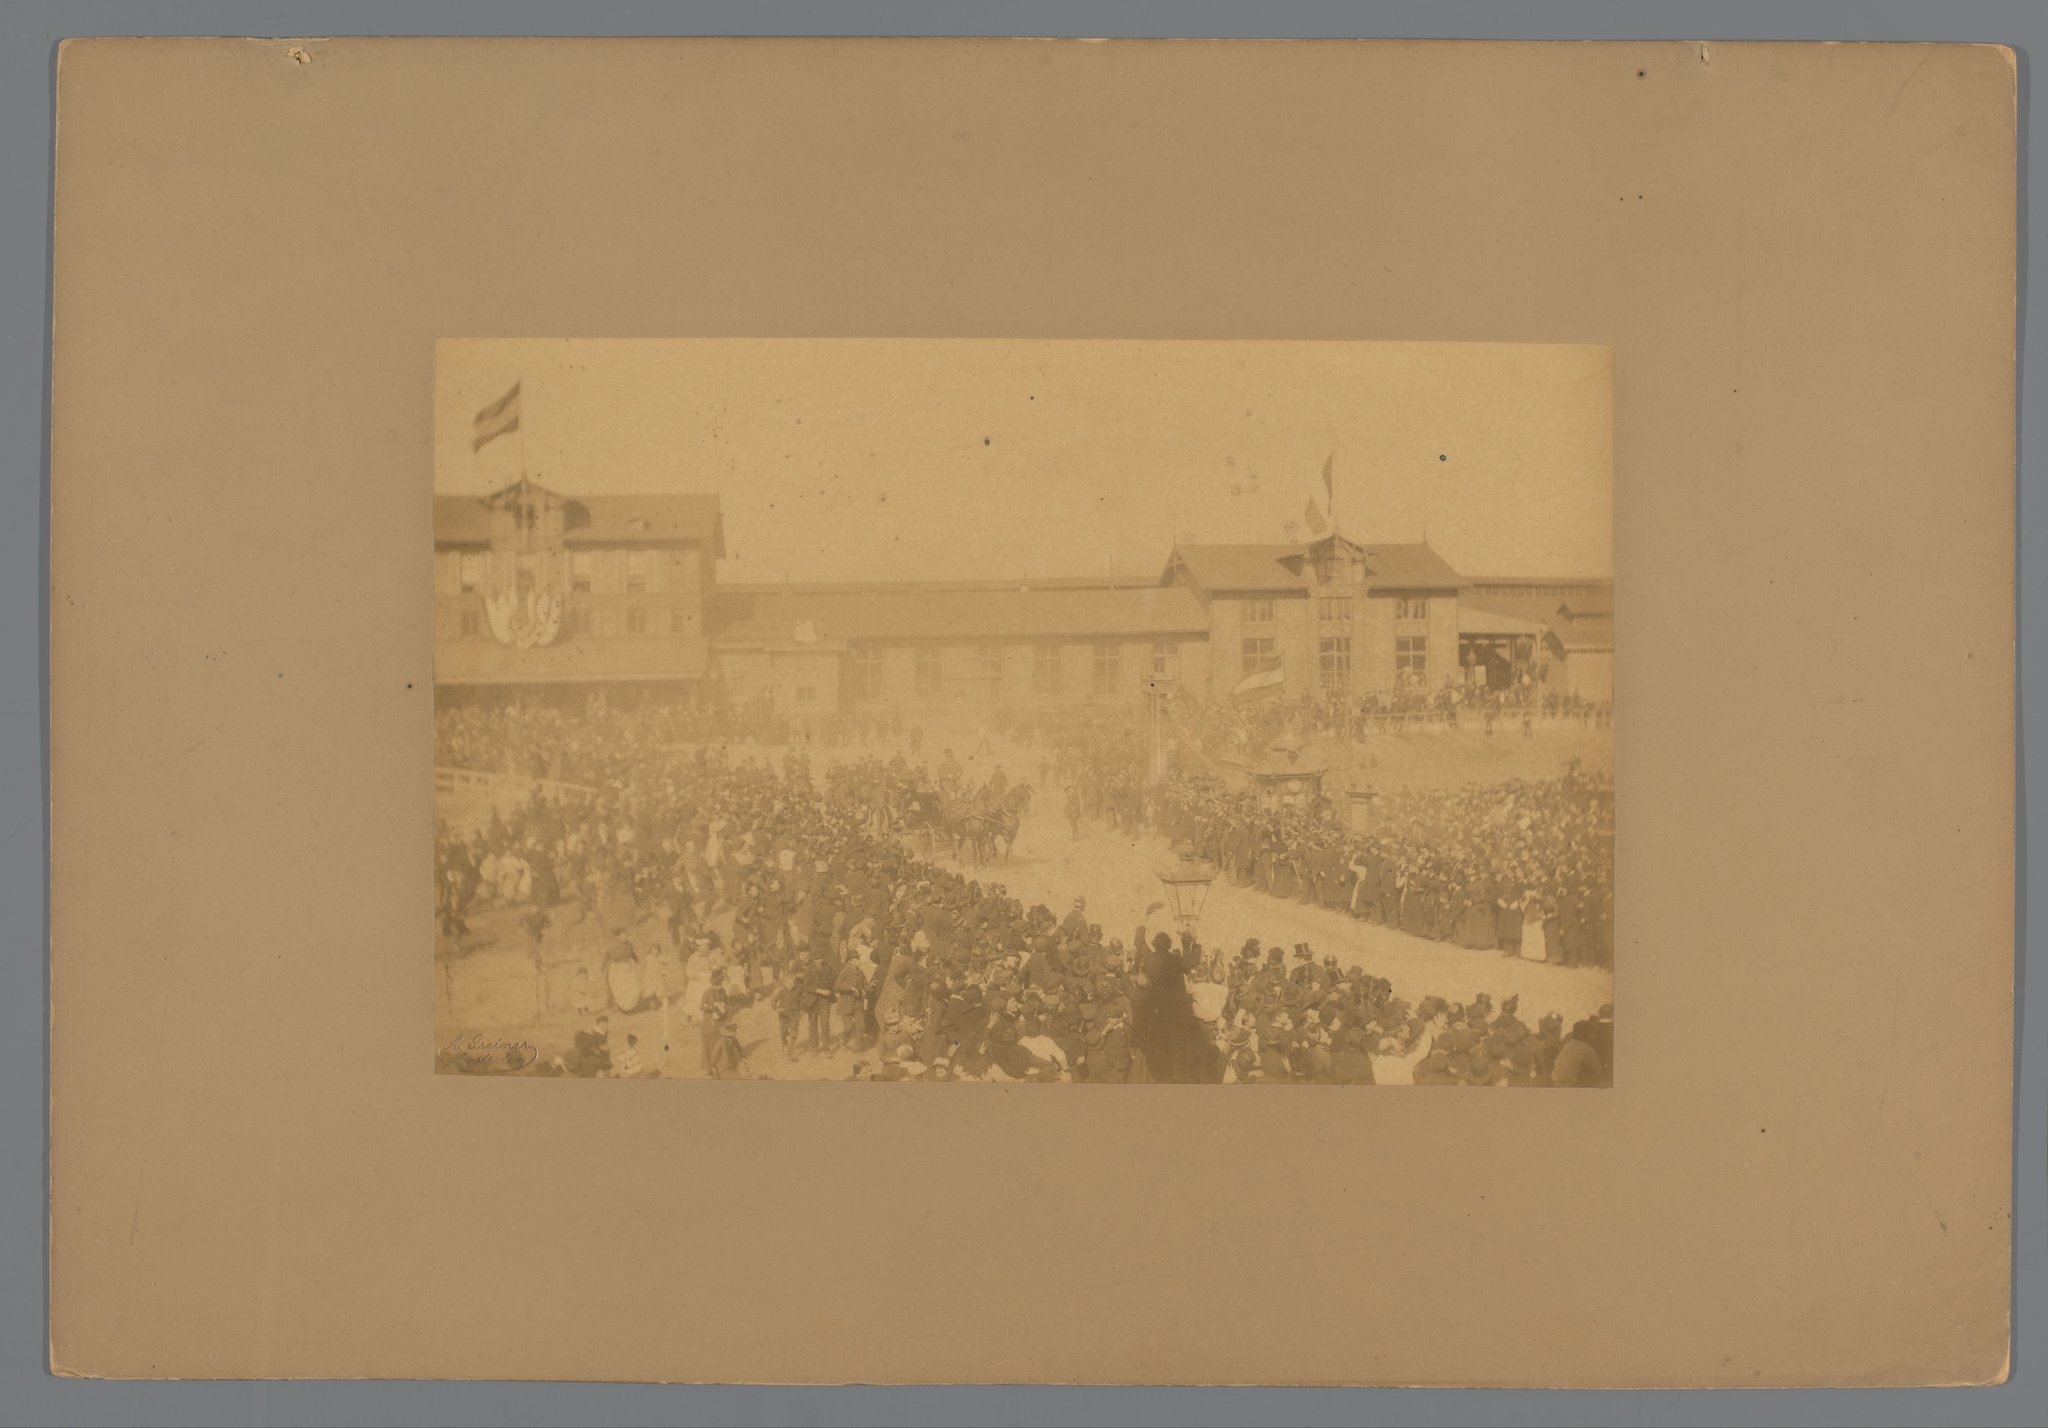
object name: photograph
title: Herinnering Aprilfeesten 1887 Amsterdam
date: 1887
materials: cardboard, paper, photographic support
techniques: albumen print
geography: amsterdam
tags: emma (queen consort of the netherlands), public festivities on the occasion of royal events, amsterdam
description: Het vertrek van de stoet vanaf het treinstation. Onderdeel van een ensemble bestaande uit zes losse foto's, een titelblad en vijf tekstbladen. Naar aanleiding van de Aprilfeesten gevierd te Amsterdam op 13 april 1887, ter gelegenheid van de 70e verjaardag van koning Willem III. Uitgegeven ten voordele van het Genootschap Liefdadigheid naar Vermogen.